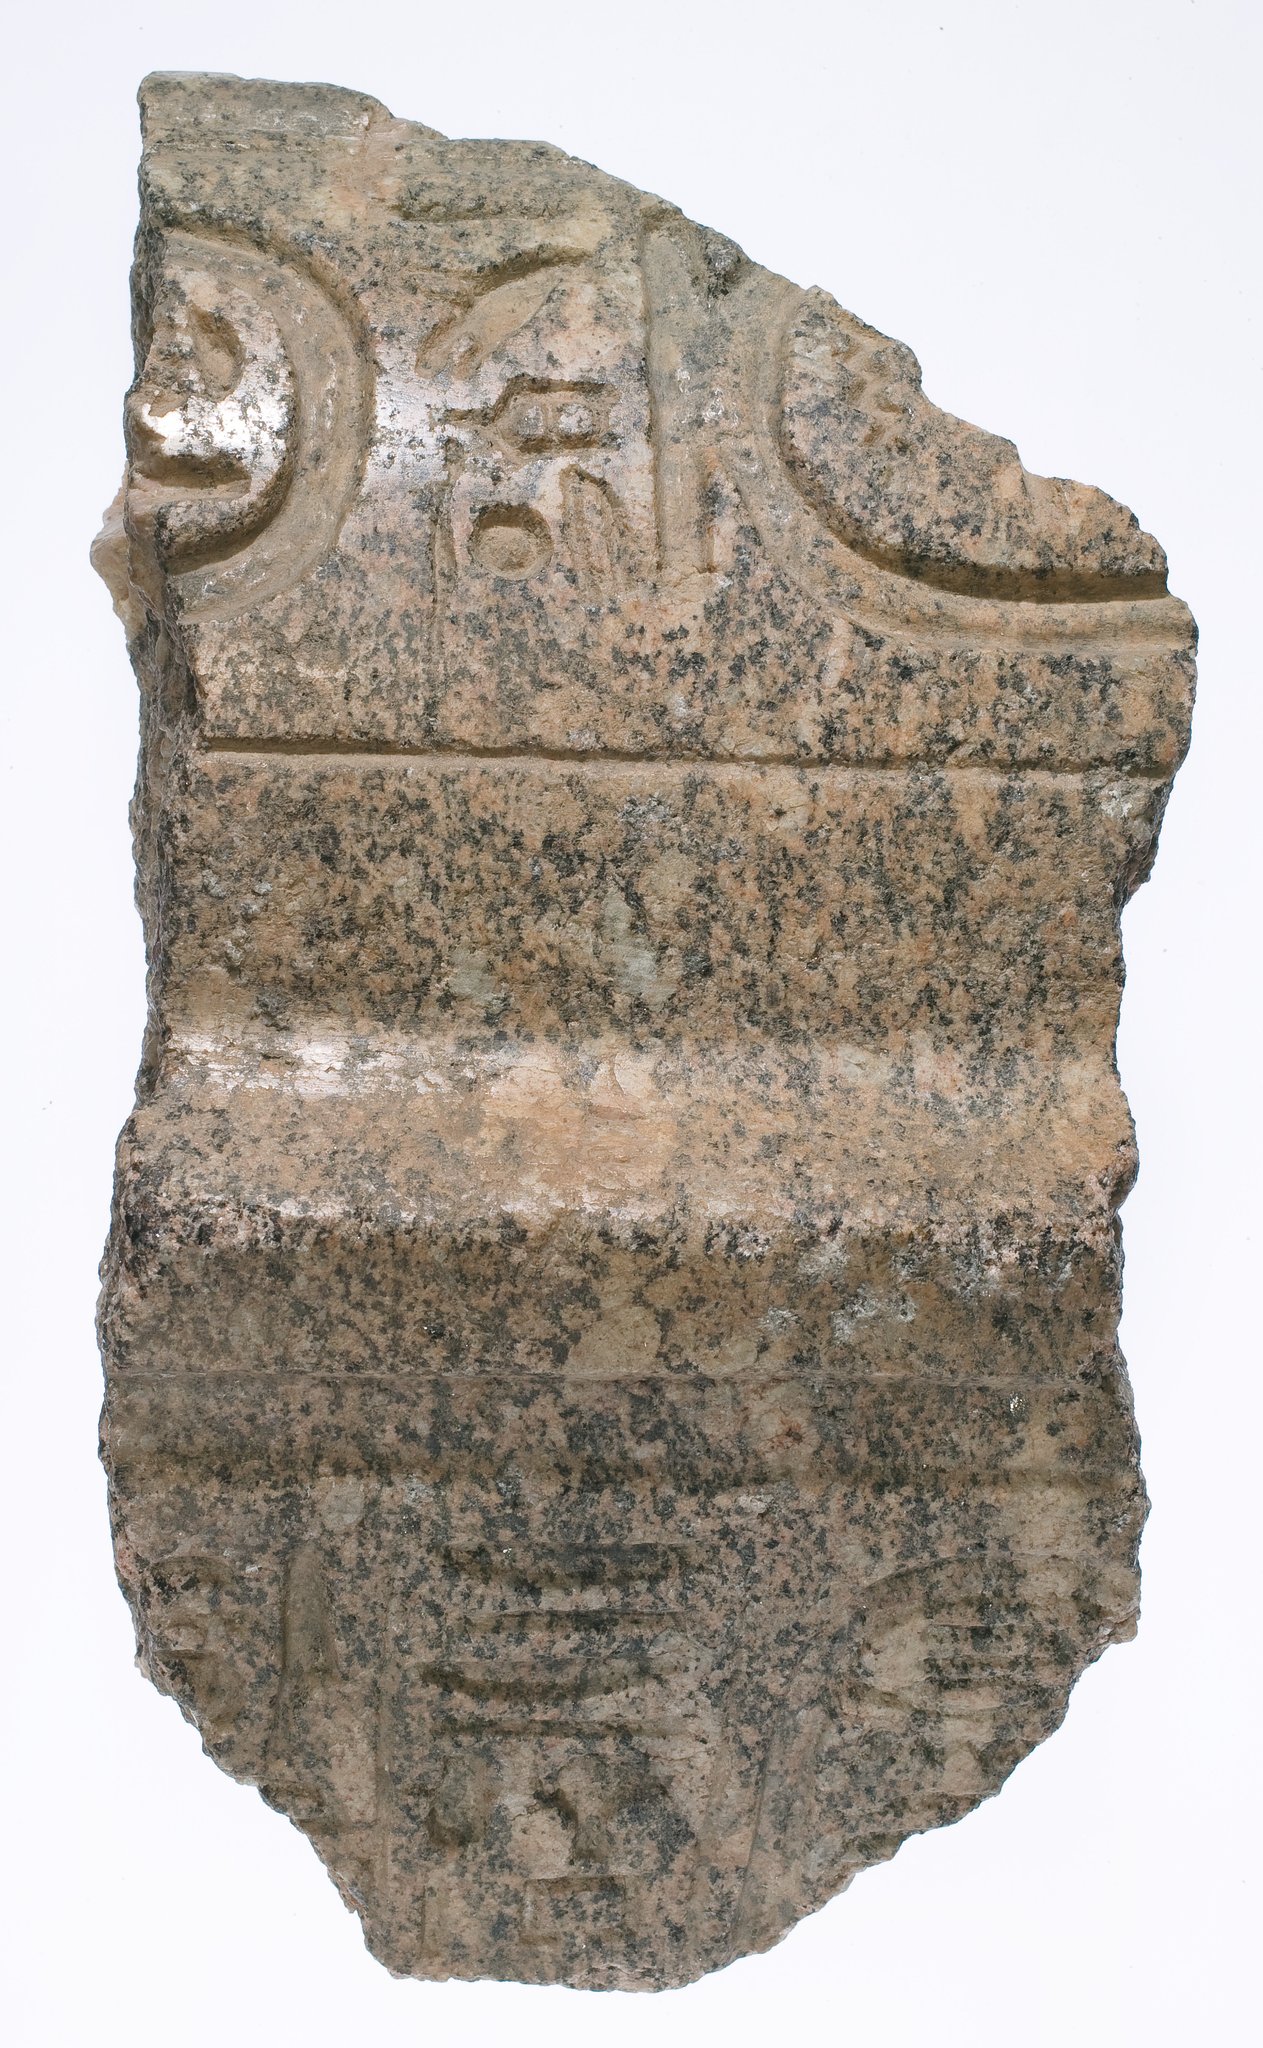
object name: balustrade, akhenaten and aten cartouch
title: Balustrade fragment with the cartouches of the Aten and Akhenaten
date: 1352-1336 BCE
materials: granite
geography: egypt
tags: cartouches